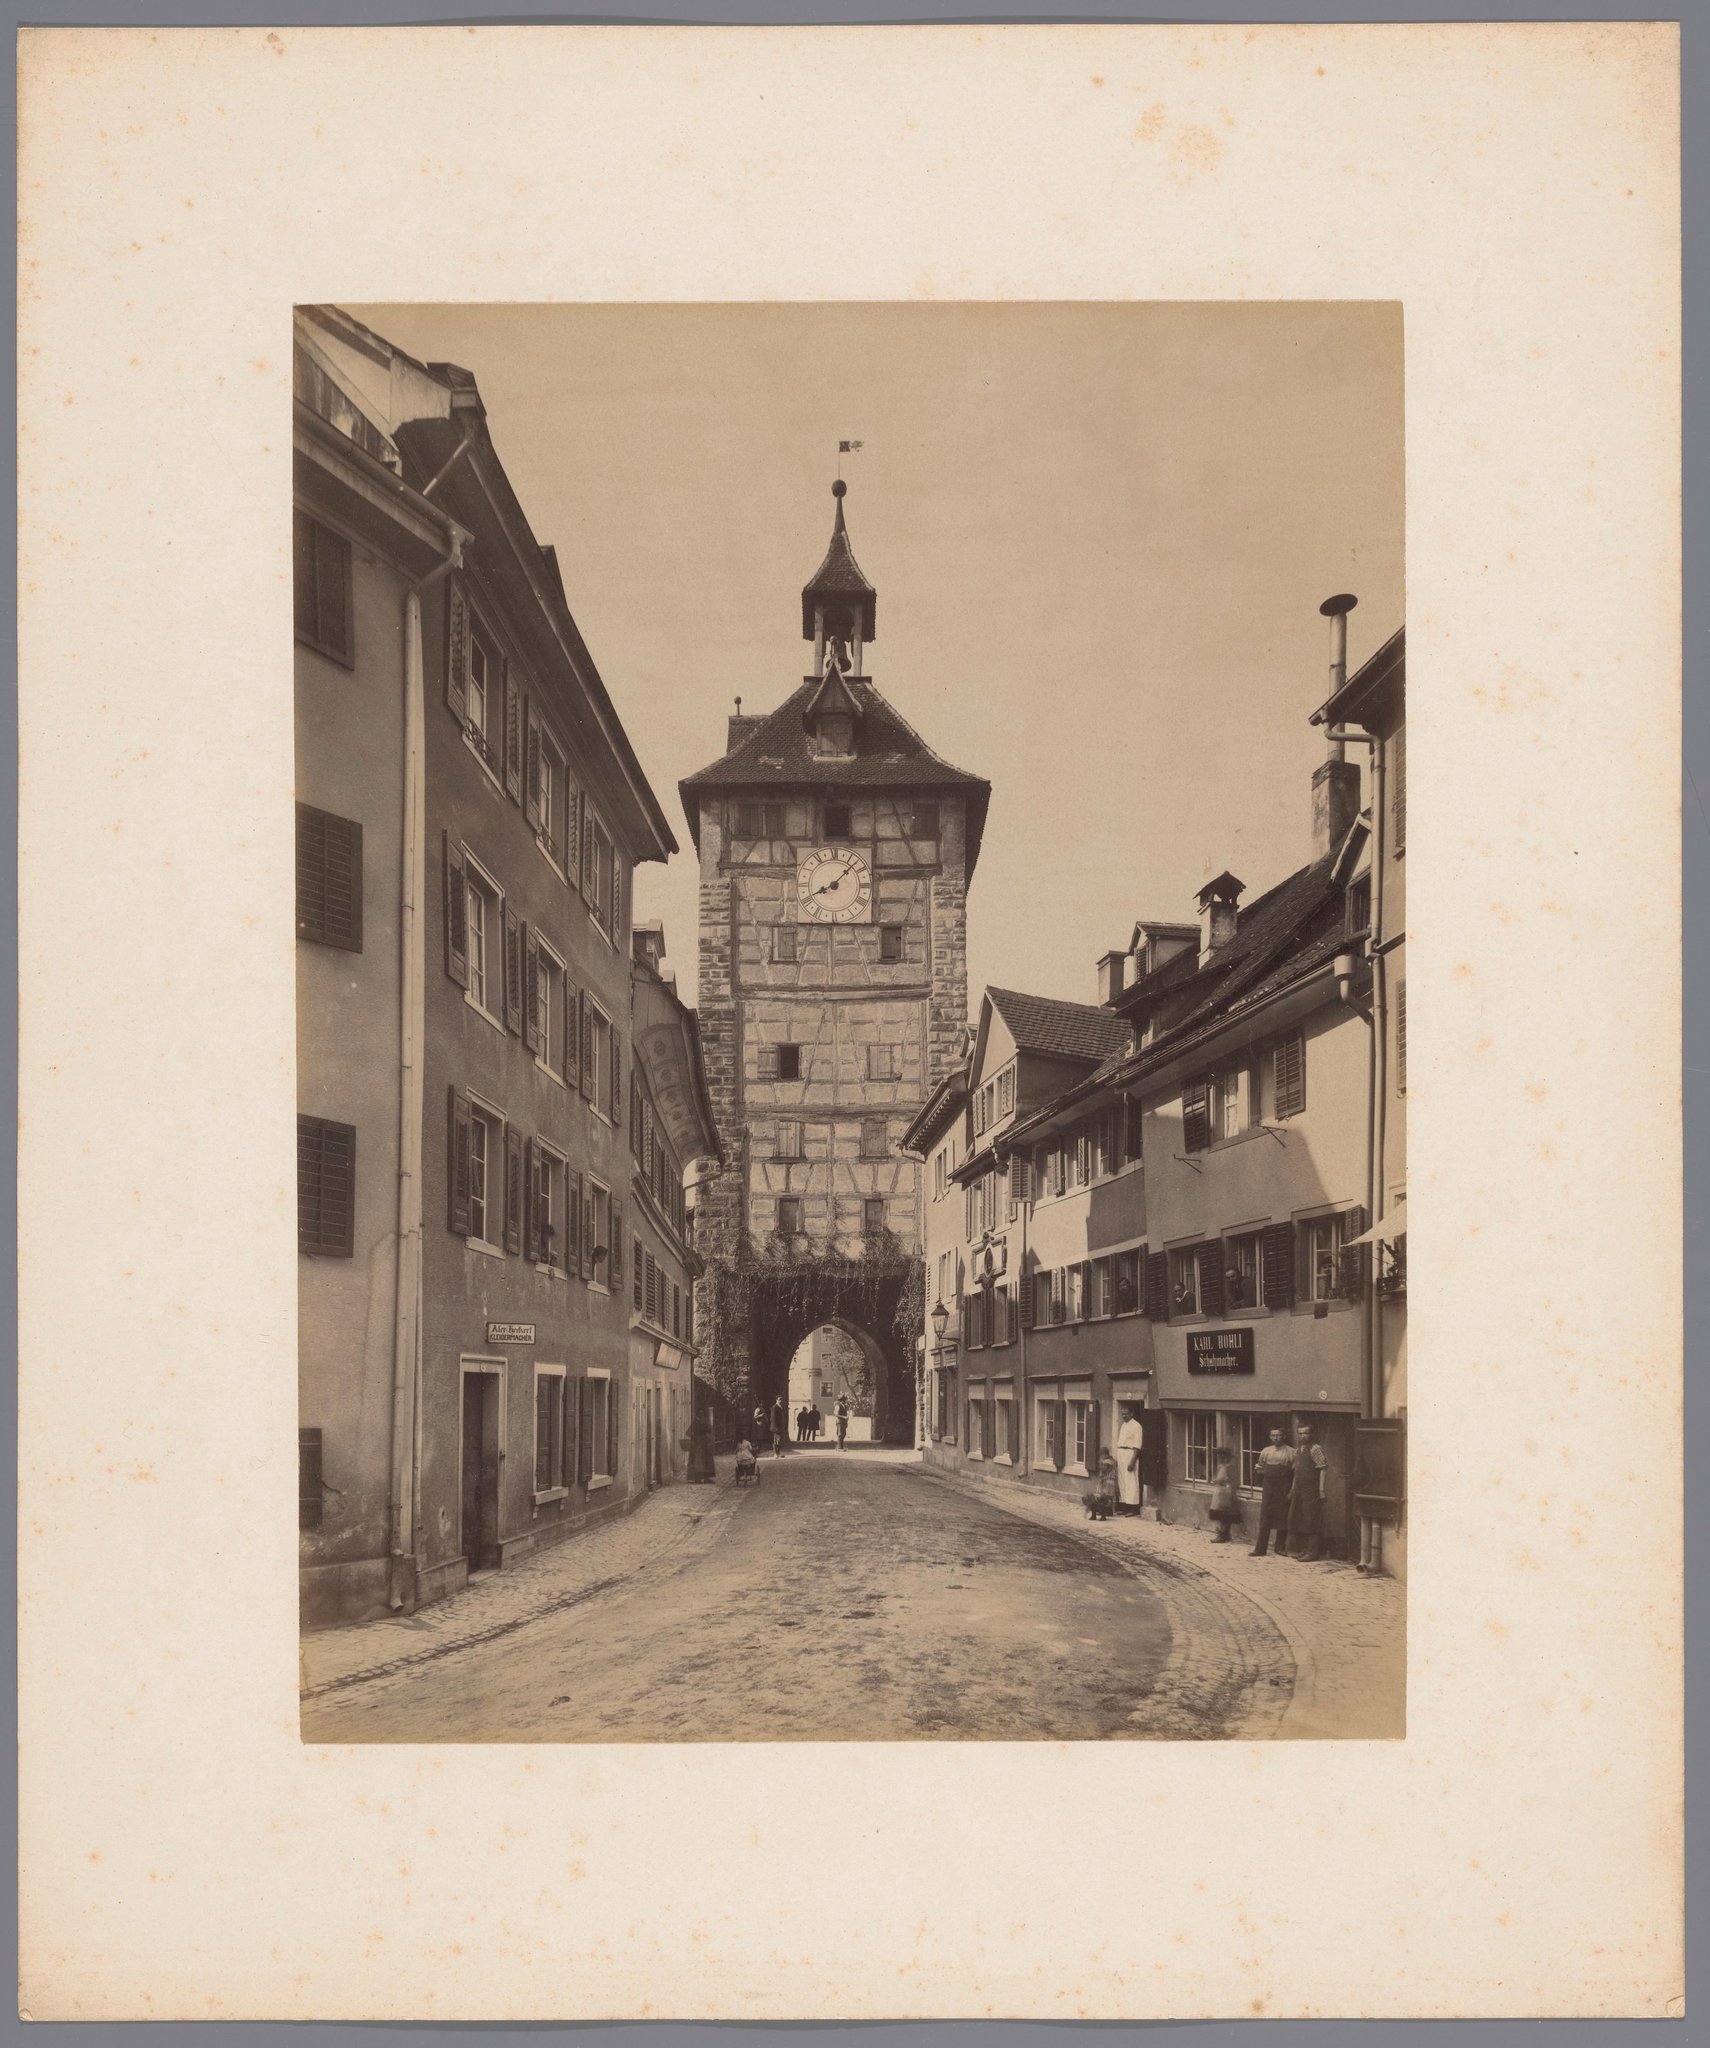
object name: photograph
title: Straatgezicht met uitzicht op de Schnetztor in Konstanz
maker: Anonymous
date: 1883-1900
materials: cardboard, paper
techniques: albumen print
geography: konstanz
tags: street, city-gate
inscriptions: inscription: ‘10. Constanz Zondag 5 Juli/ 10’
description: Deze foto maakt deel uit van een fotoserie, gemaakt of gekocht door een Nederlandse reiziger die onderweg was in Duitsland, Oostenrijk en Italië tussen 27 juni en 29 juli. Het jaartal van de reis is onbekend, maar de foto's zijn waarschijnlijk gemaakt tussen 1883 en 1900.